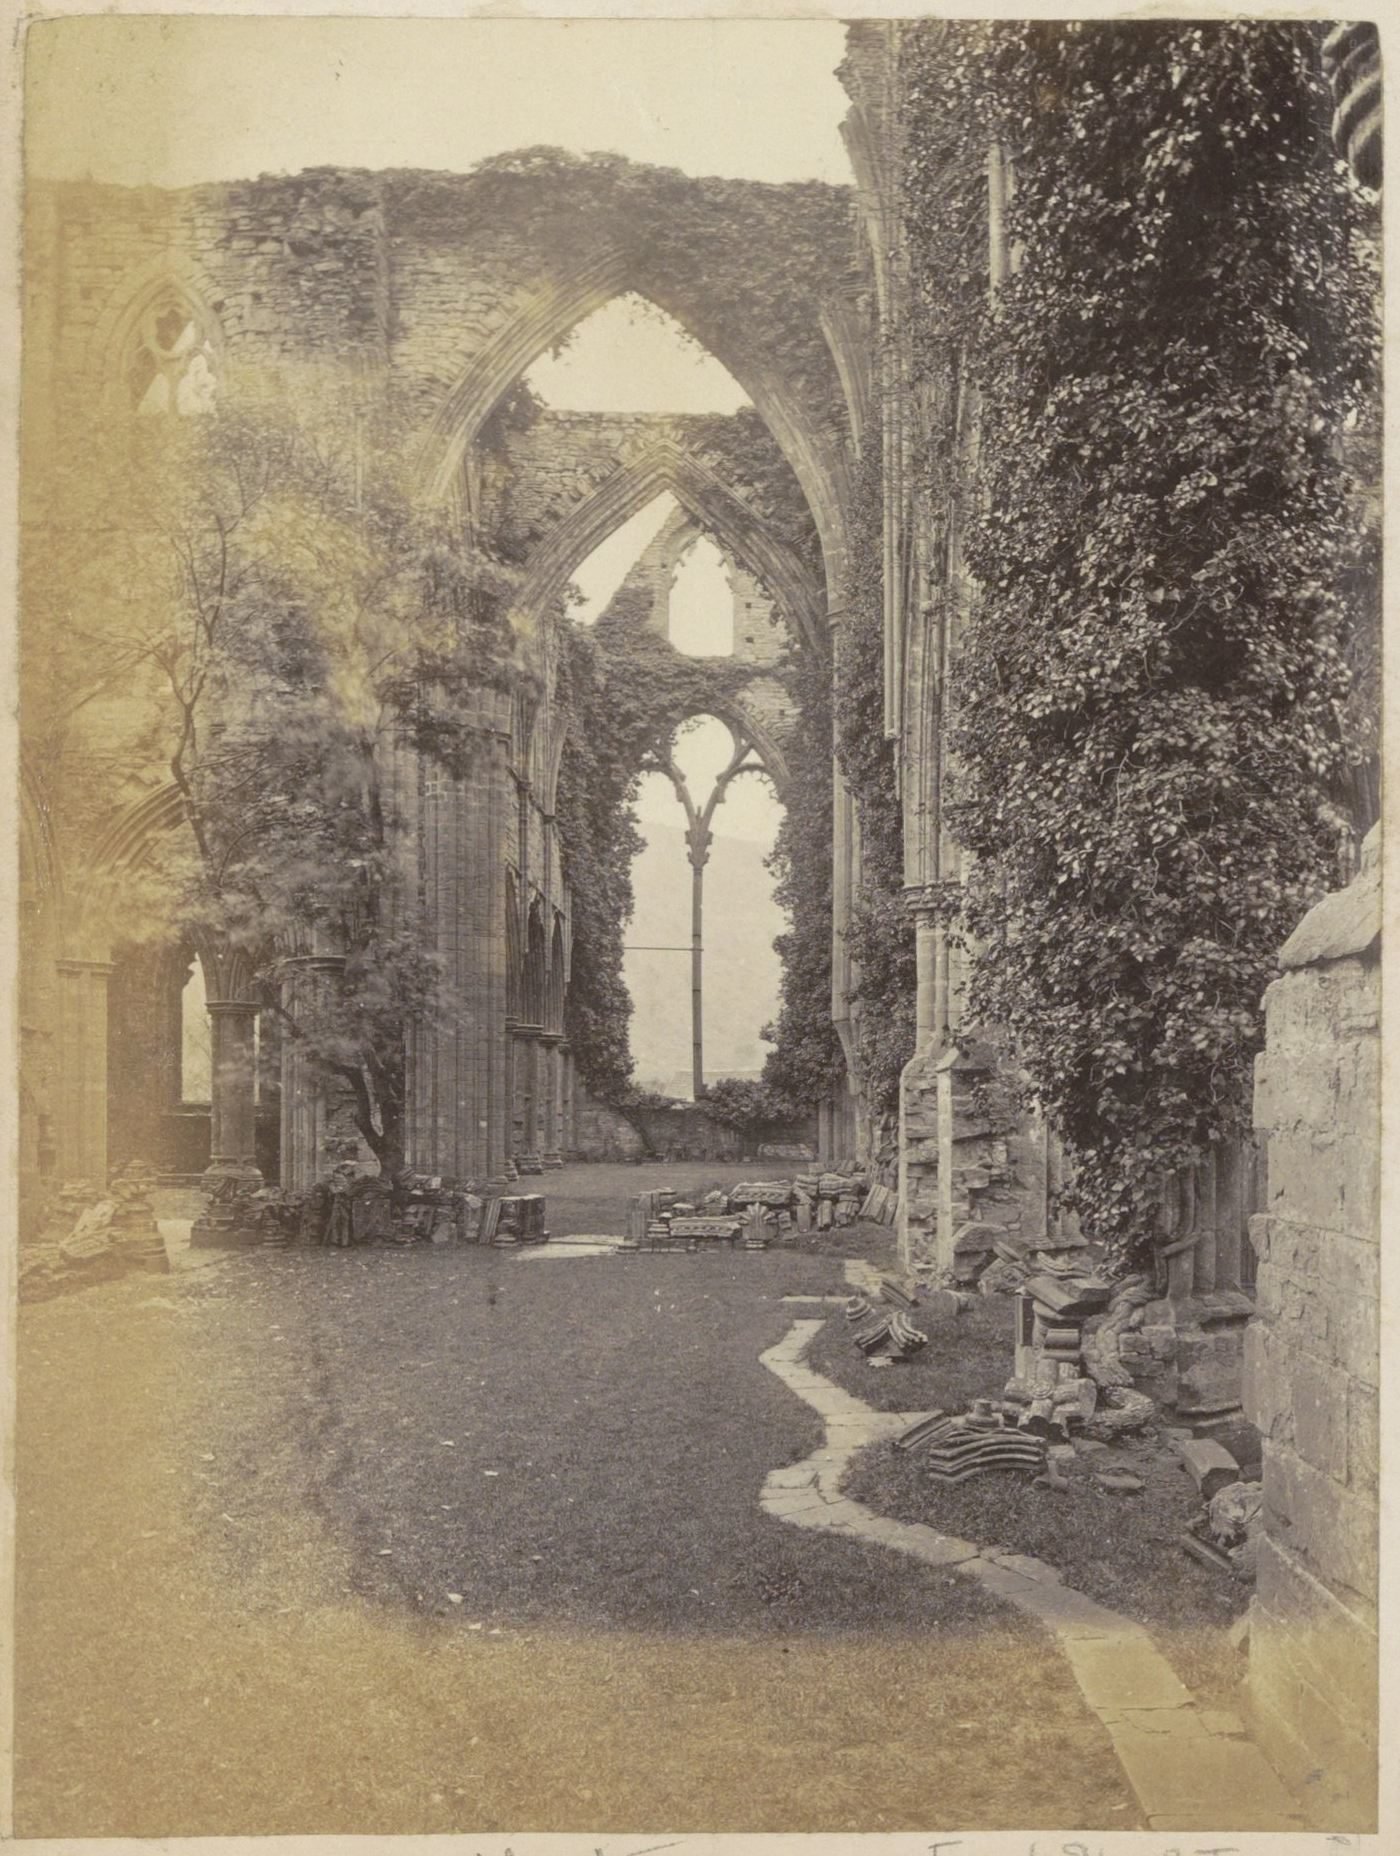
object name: photograph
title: Ruïne van Tintern Abbey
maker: Anonymous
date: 1850-1870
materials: paper, photographic support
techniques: albumen print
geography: tintern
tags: ruin of a dwelling, house, castle, etc., england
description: Onderdeel van Album met foto's van bezienswaardigheden en landschappen in Engeland en van kunst.